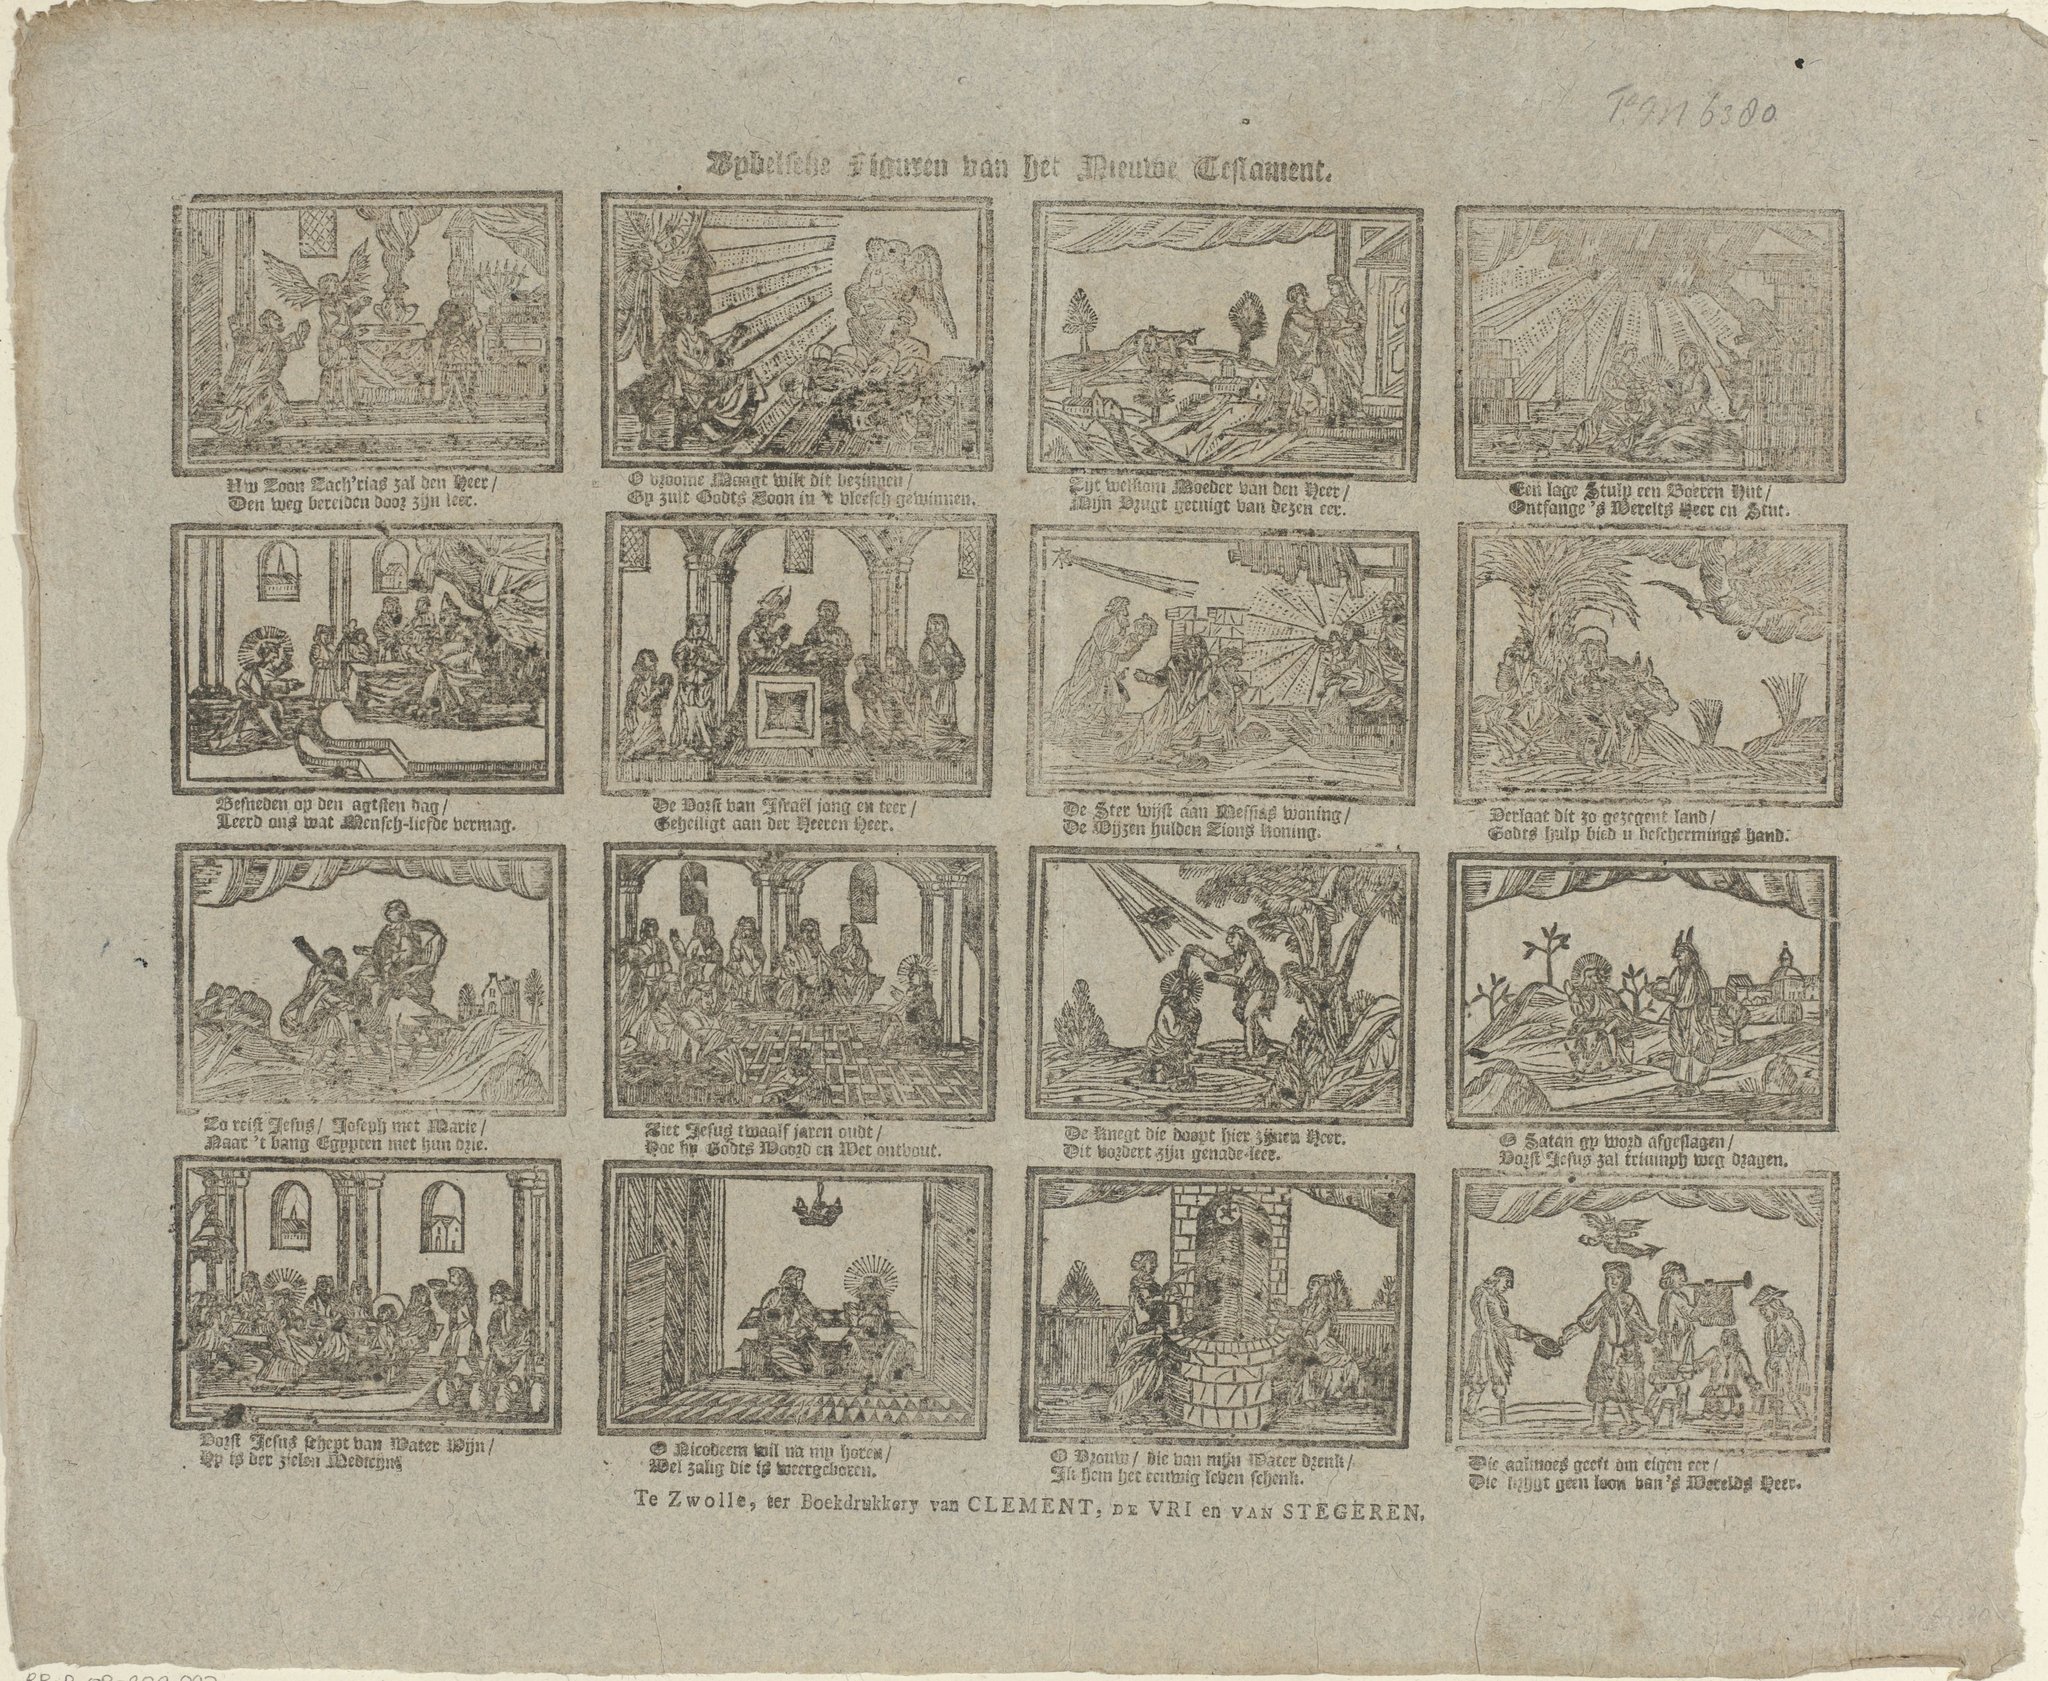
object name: popular print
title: Bybelsche figuren van het Nieuwe Testament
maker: Anonymous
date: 1816-1836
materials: paper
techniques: letterpress printing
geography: zwolle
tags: new testament, series of scenes from the life of christ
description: Blad met 16 voorstellingen uit het Nieuwe Testament, waaronder de Annunciatie, de vlucht naar Egypte en de doop in de Jordaan. Onder elke voorstelling een tweeregelig vers.